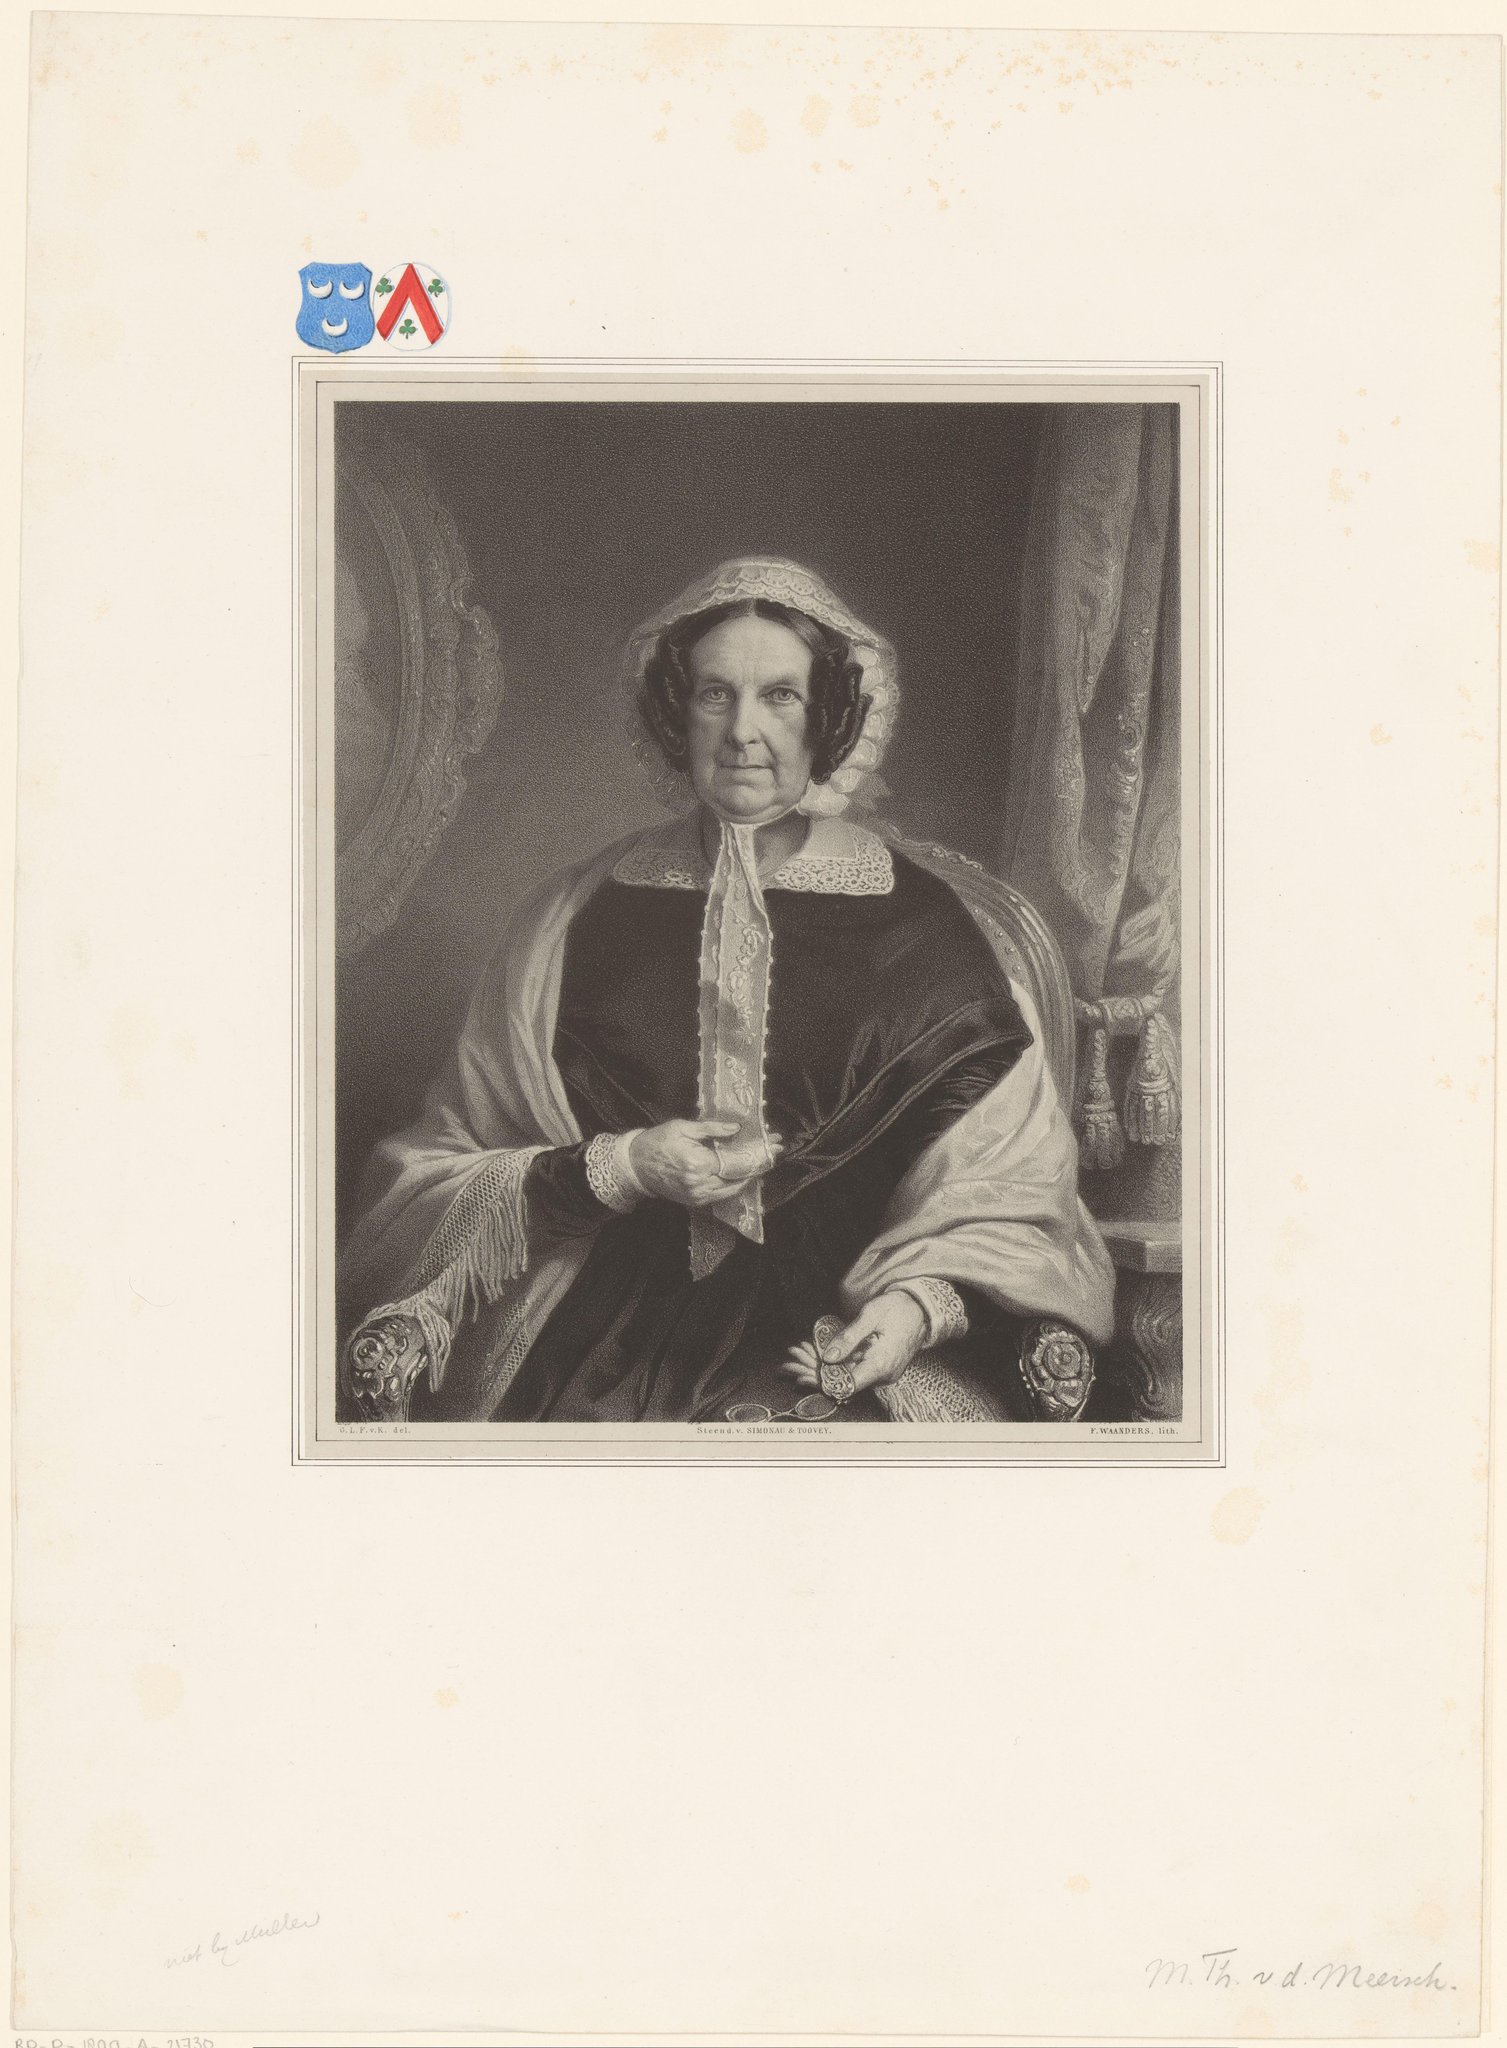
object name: print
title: Portret van Maria Theodora van der Meersch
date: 1847-1875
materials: paper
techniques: lithograph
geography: brussels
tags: the hague, historical persons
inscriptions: collector's mark: Lugt 2228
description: Links boven het portret twee wapenschilden.